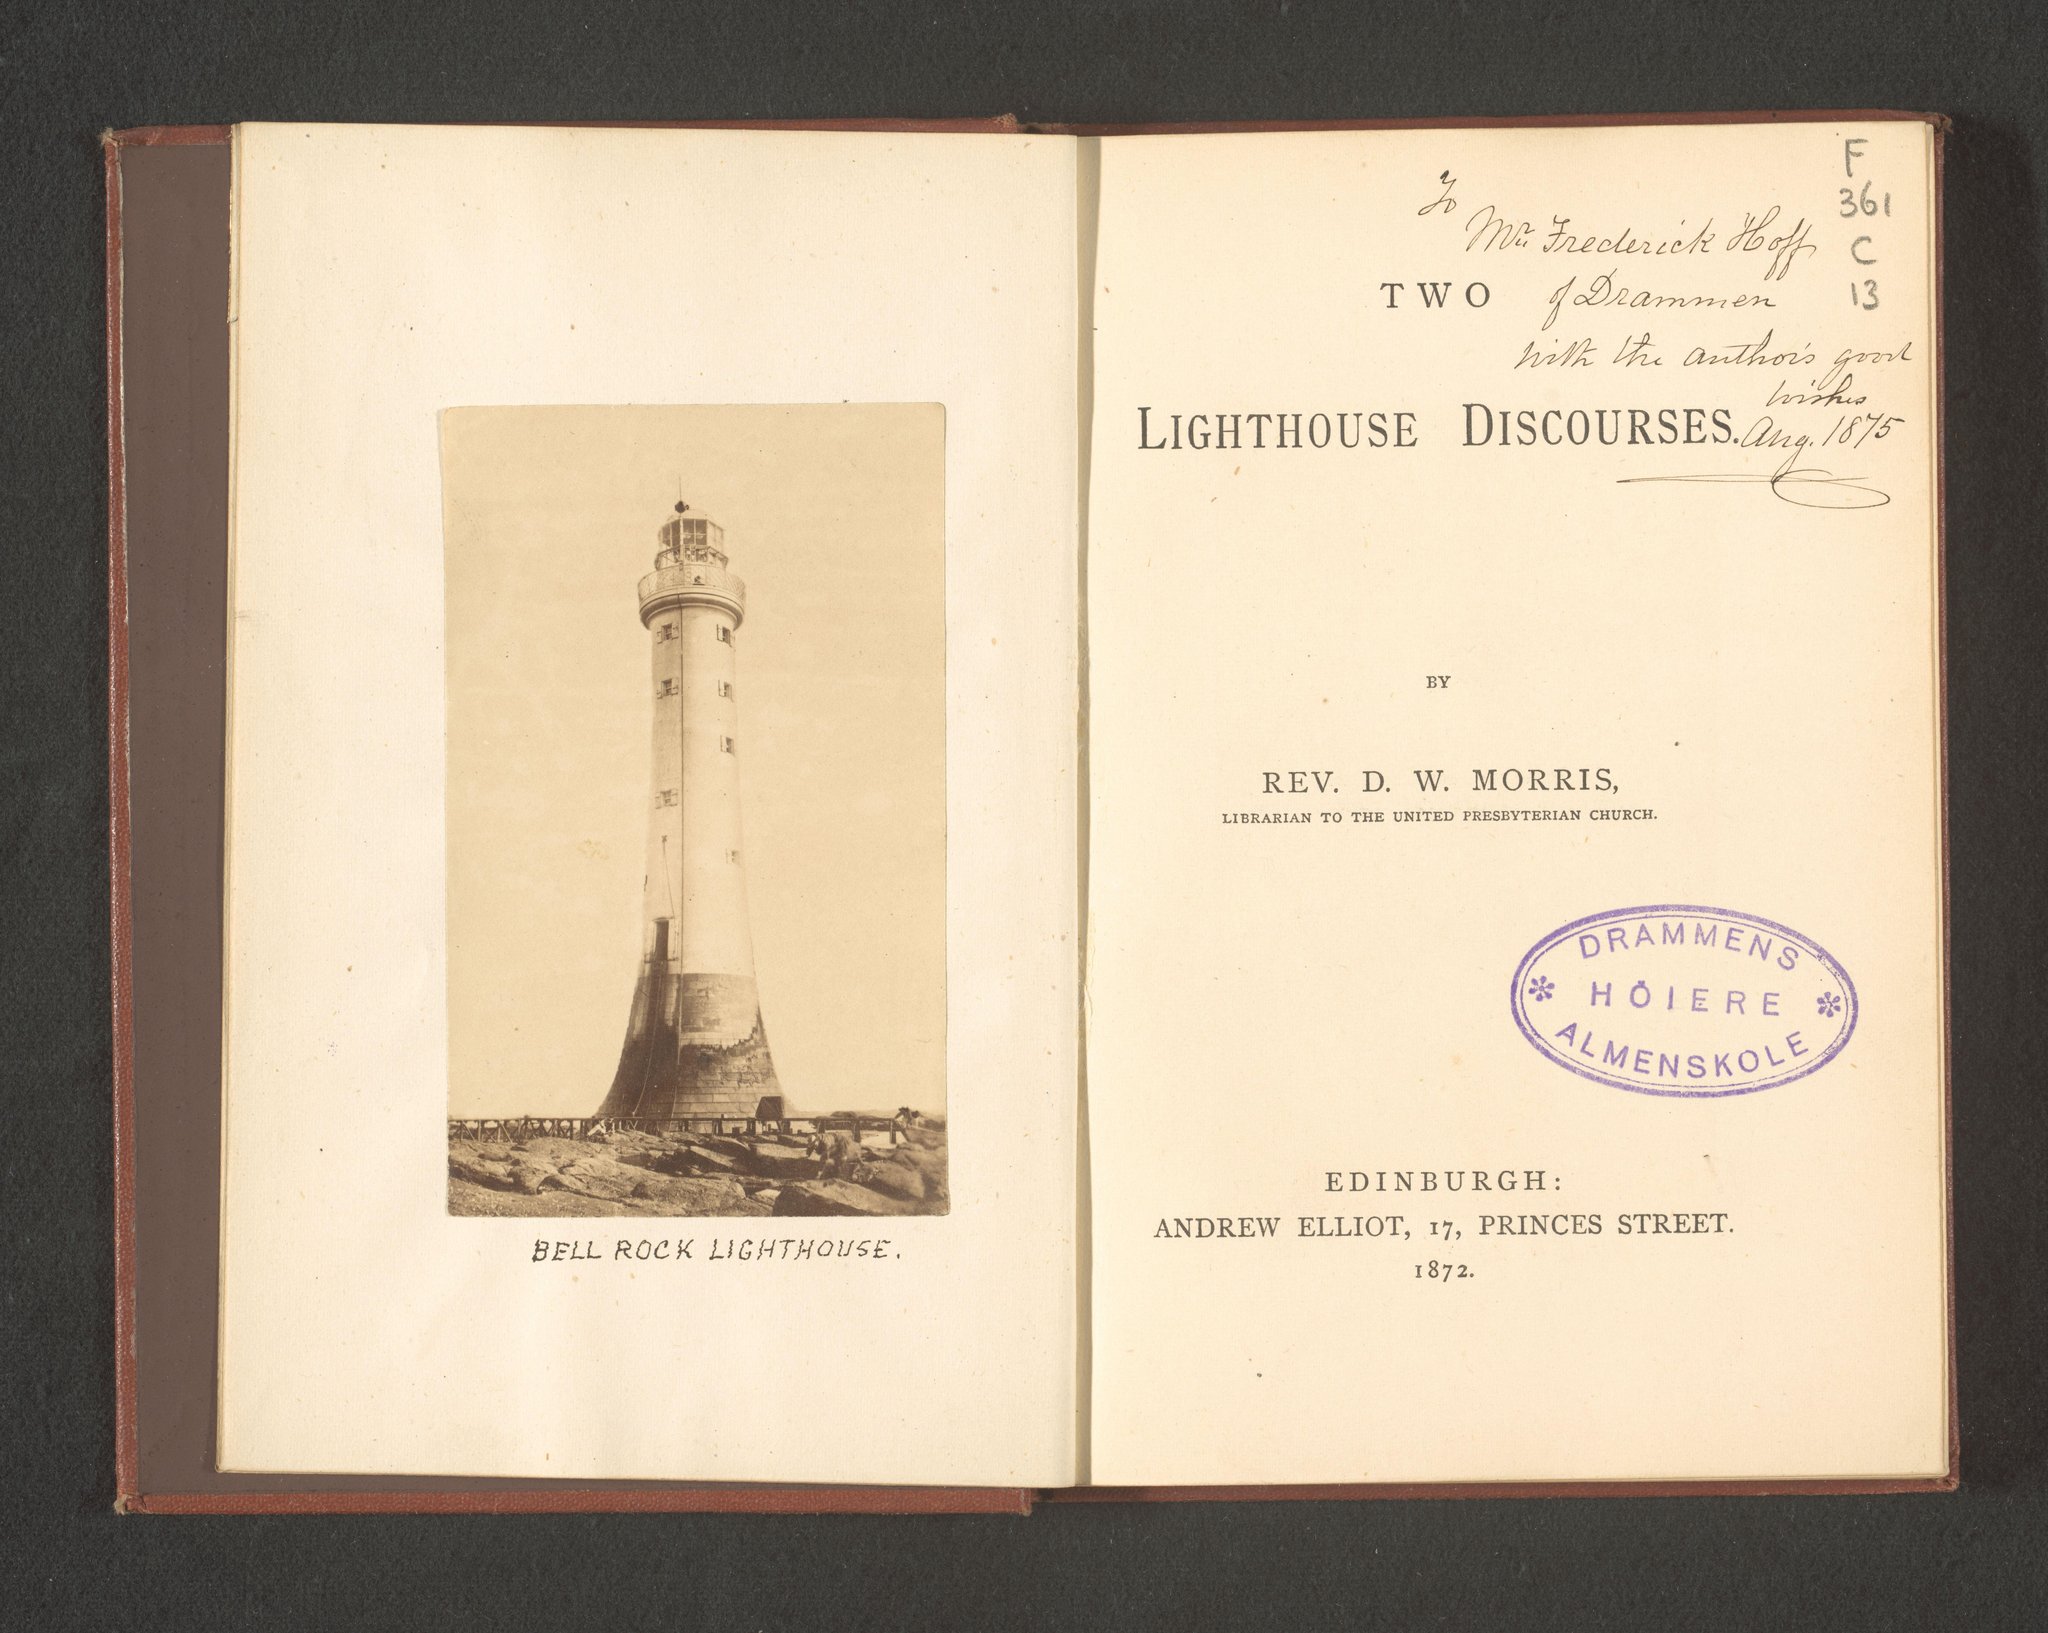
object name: photograph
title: Bell Rock Lighthouse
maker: Anonymous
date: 1867-1872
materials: photographic support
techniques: albumen print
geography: scotland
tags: lighthouse, lightship, sea